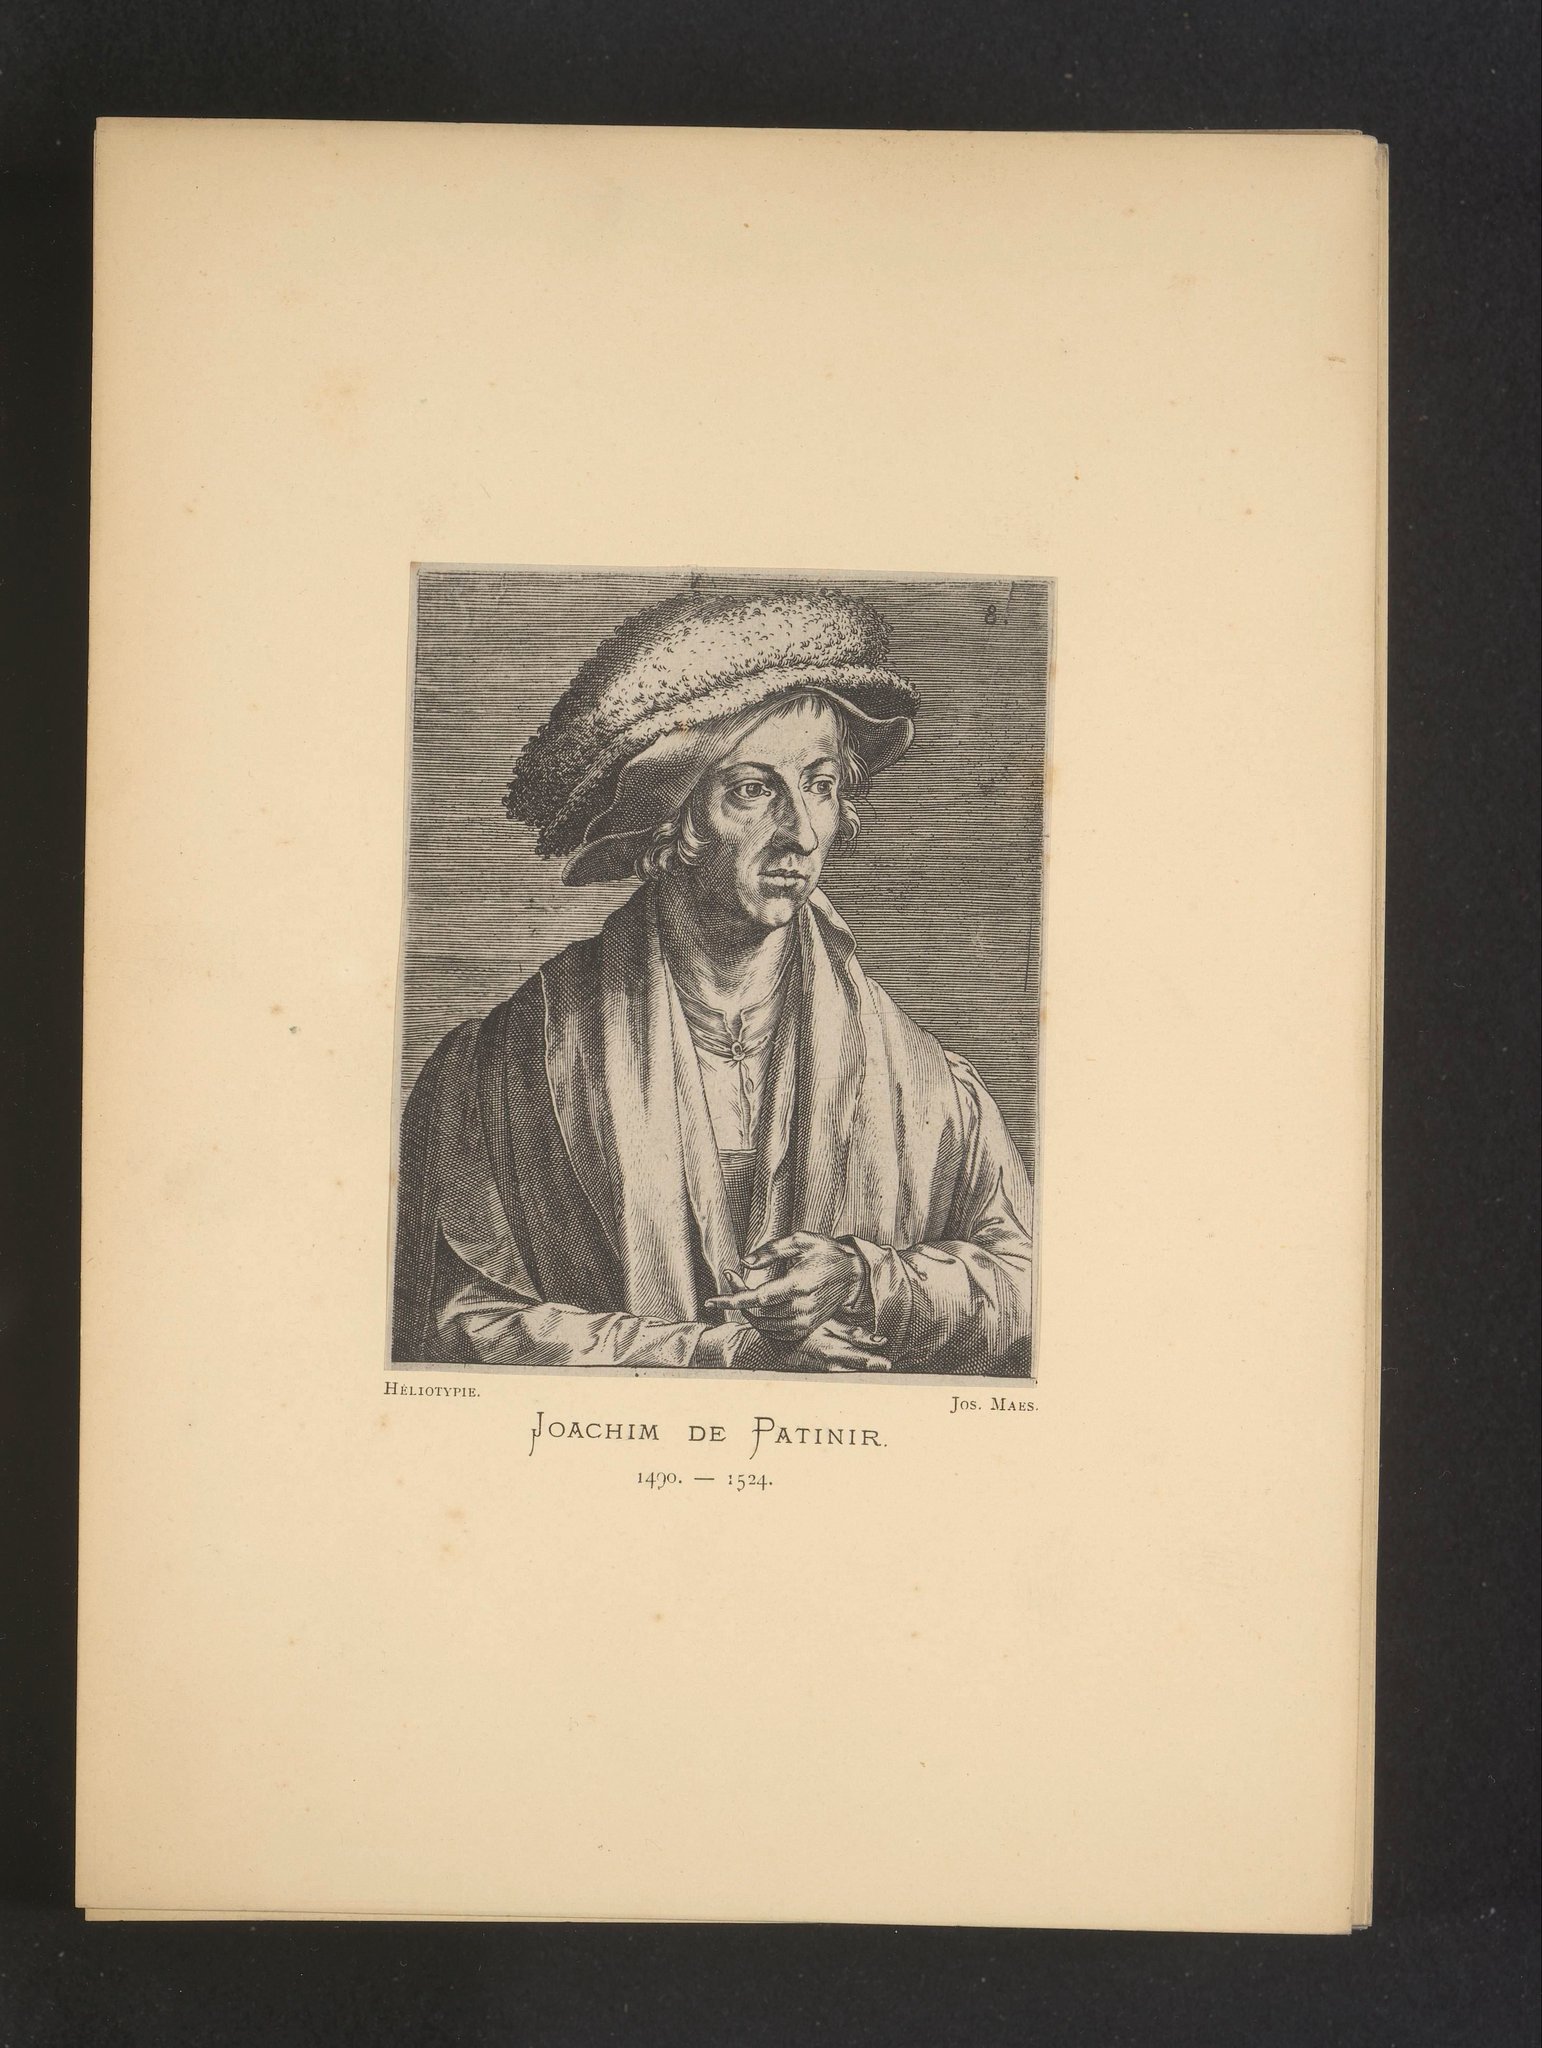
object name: photomechanical print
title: Joachim de Patinir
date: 1872-1877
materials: cardboard, paper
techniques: photograph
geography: antwerp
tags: painter, joachim patinir, historical persons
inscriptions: inscription: ‘1490. - 1524.’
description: Deze prent maakt deel uit van een omslag met 150 prenten en een katern met een lijst van afbeeldingen.